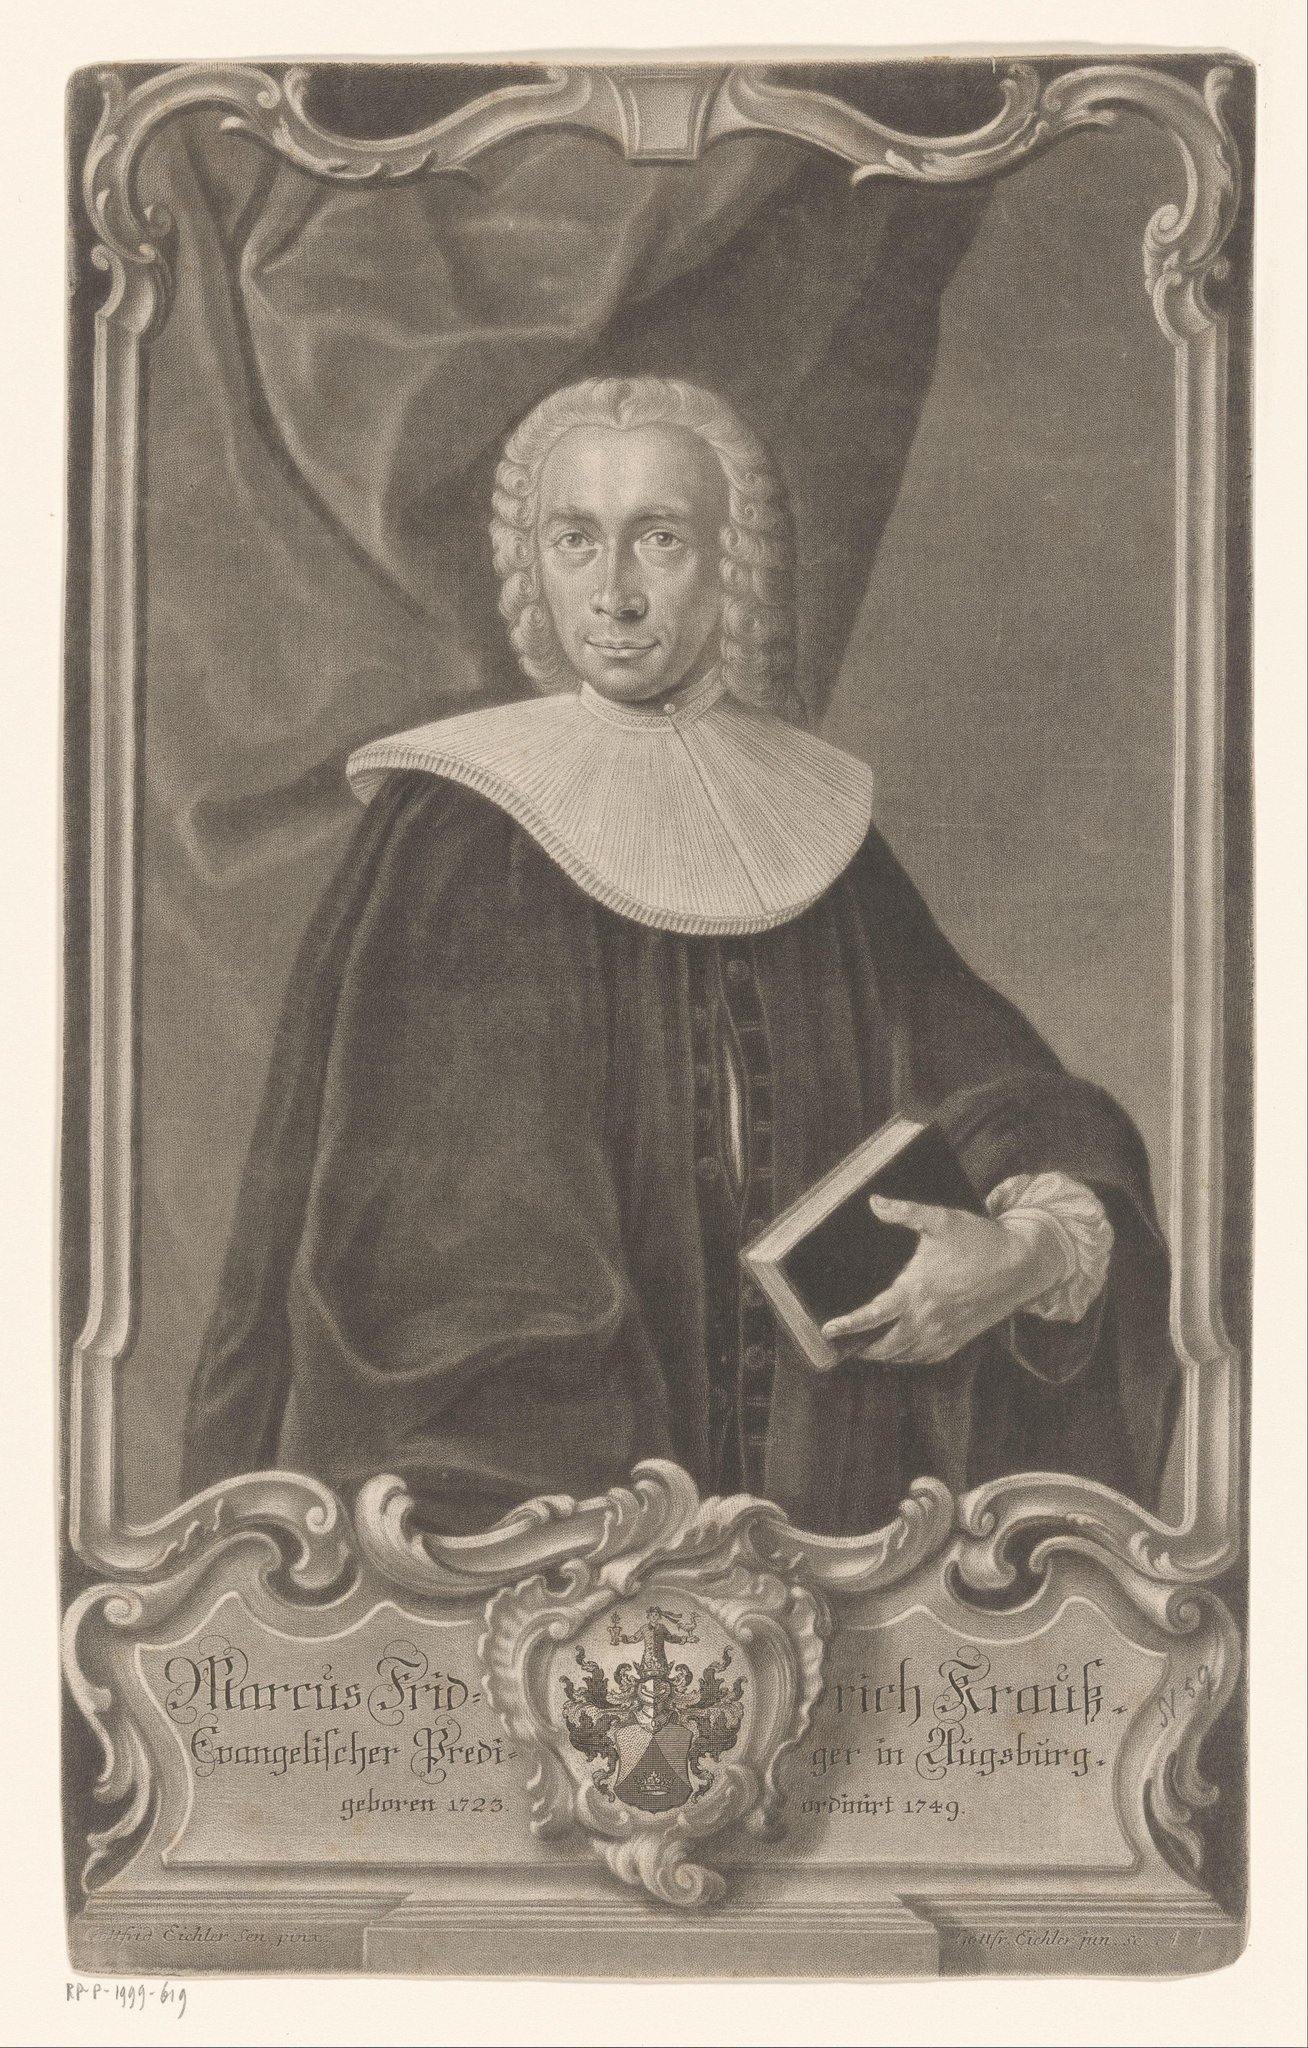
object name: print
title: Portret van Marcus Friedrich Kraus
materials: paper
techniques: etching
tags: historical persons, book, functionaries and dignitaries (with name) ~ episcopal protestant churches, armorial bearing, heraldry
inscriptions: collector's mark: Lugt 2760, collector's mark: Lugt 2228